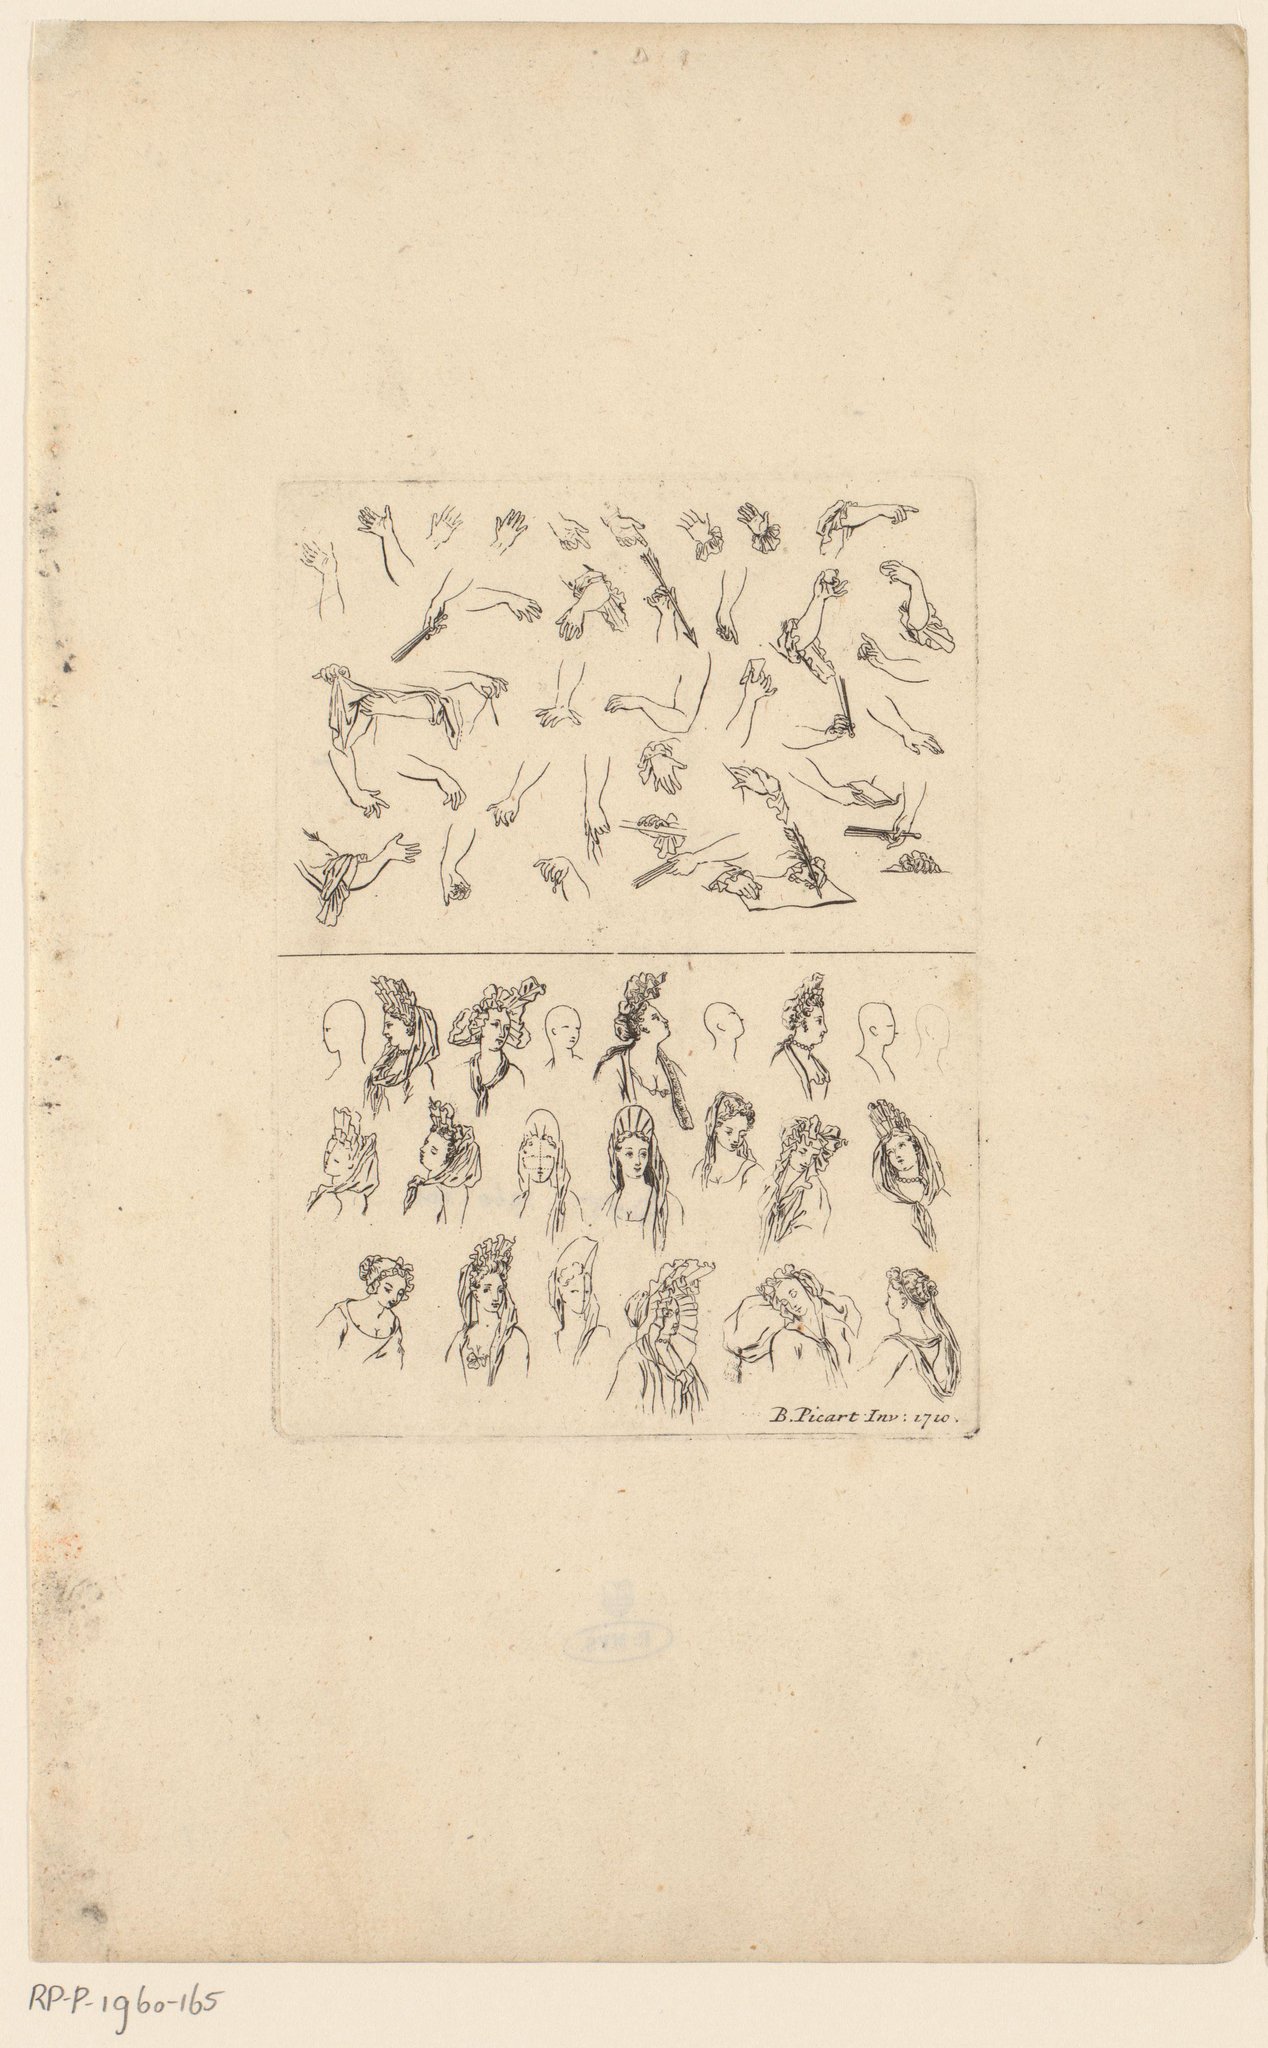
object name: print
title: Studiebladen met modeverschijnselen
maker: bernard picart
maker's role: draughtsman, print maker, publisher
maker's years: 1673-1733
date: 1710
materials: paper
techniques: etching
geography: paris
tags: postures and gestures of arms and hands, fashion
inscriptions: collector's mark: Lugt 2760, collector's mark: Lugt 2228